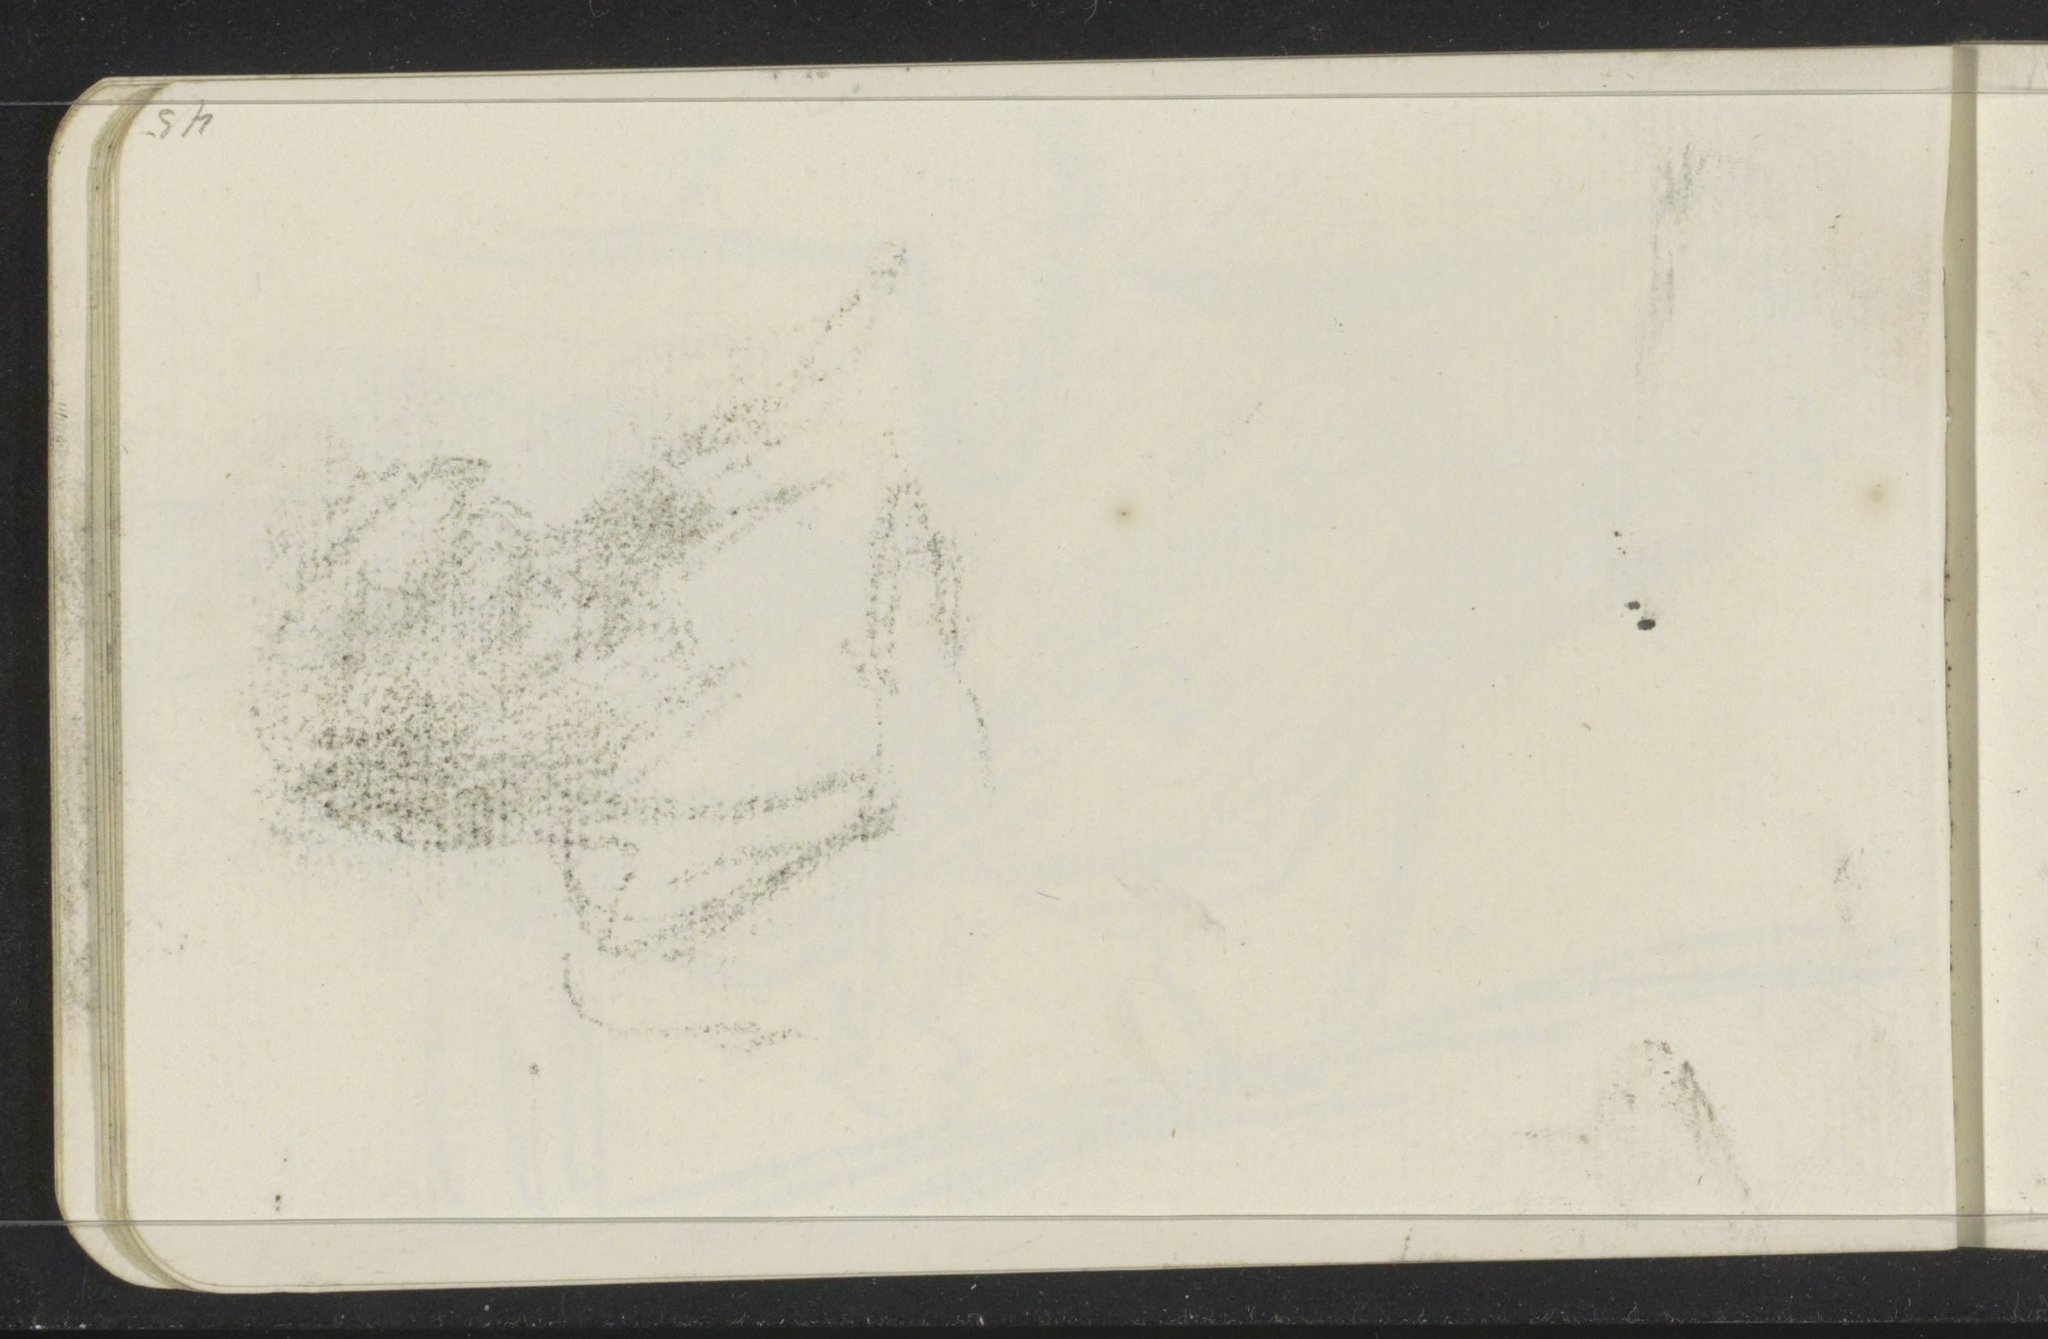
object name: sketchbook leaf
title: Abklatsch van de krijttekening op blad 13 recto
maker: isaac israels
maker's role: draughtsman, painter, print maker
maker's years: 1865-1934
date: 1875-1934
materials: paper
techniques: printmaking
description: Blad 12 verso uit schetsboek LXII met 28 bladen.